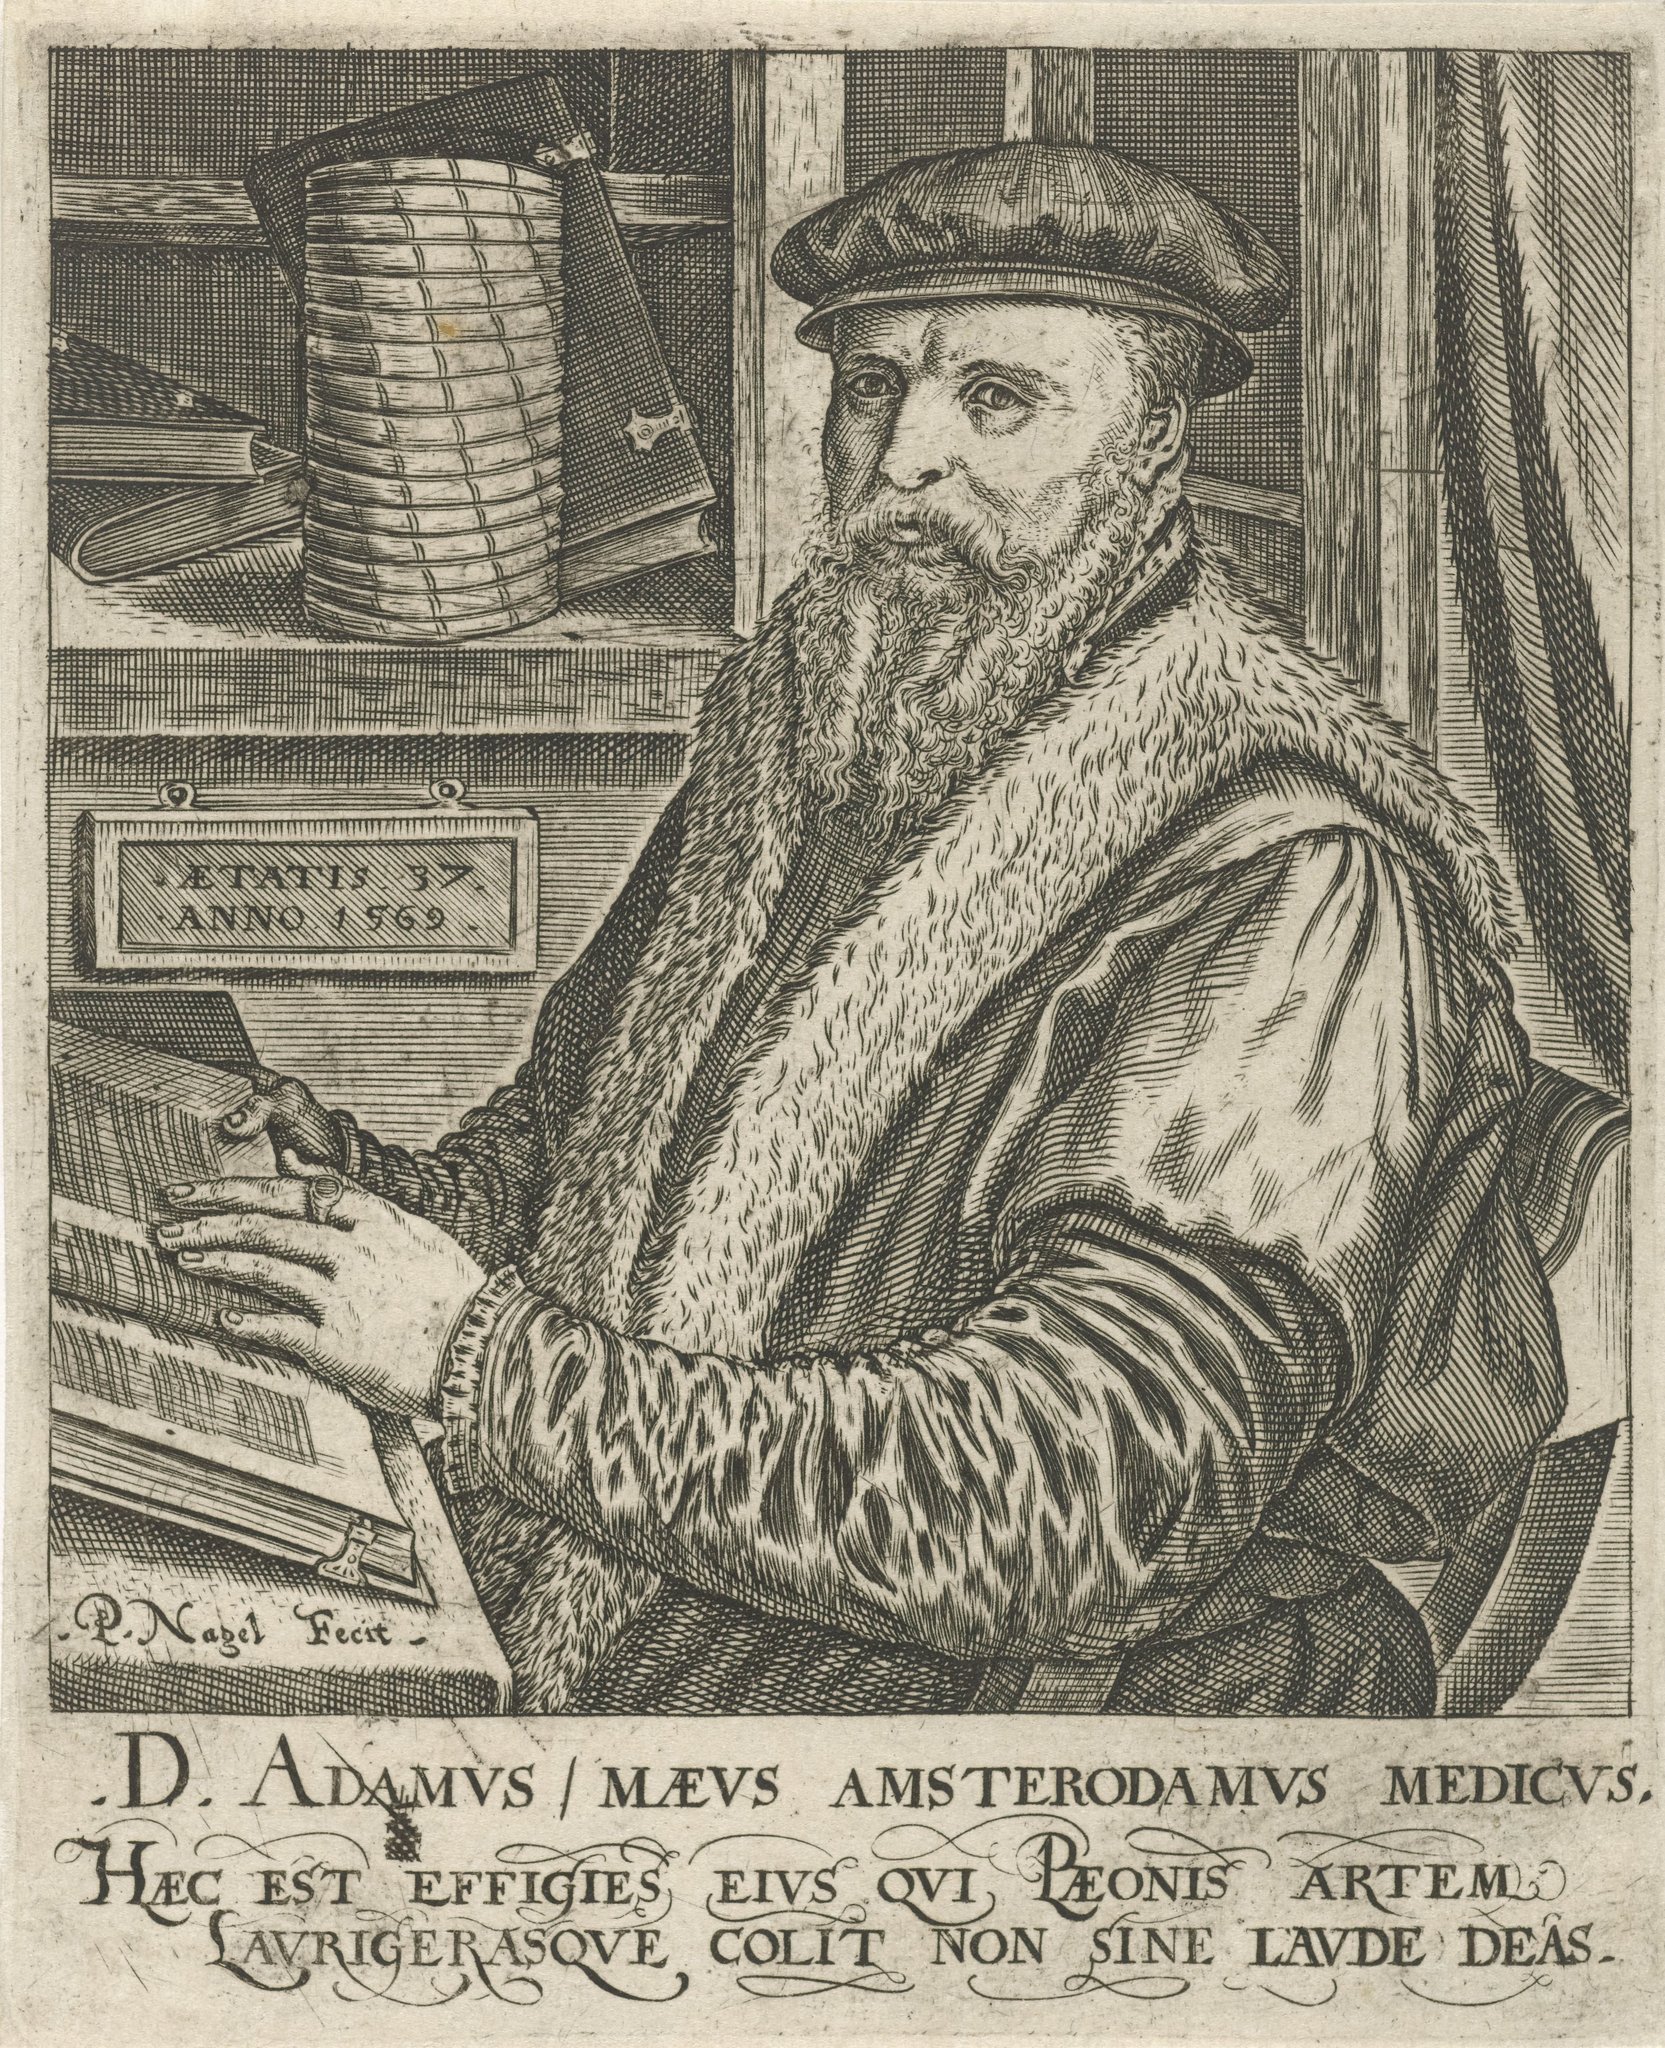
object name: print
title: Portret van Adam Maeus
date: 1569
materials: paper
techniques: engraving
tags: adam maeus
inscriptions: collector's mark: Lugt 2228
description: Adam Maeus zittend aan een tafel, zijn handen op een opengeslagen boek. Onder in de marge een tweeregelige tekst in het Latijn.